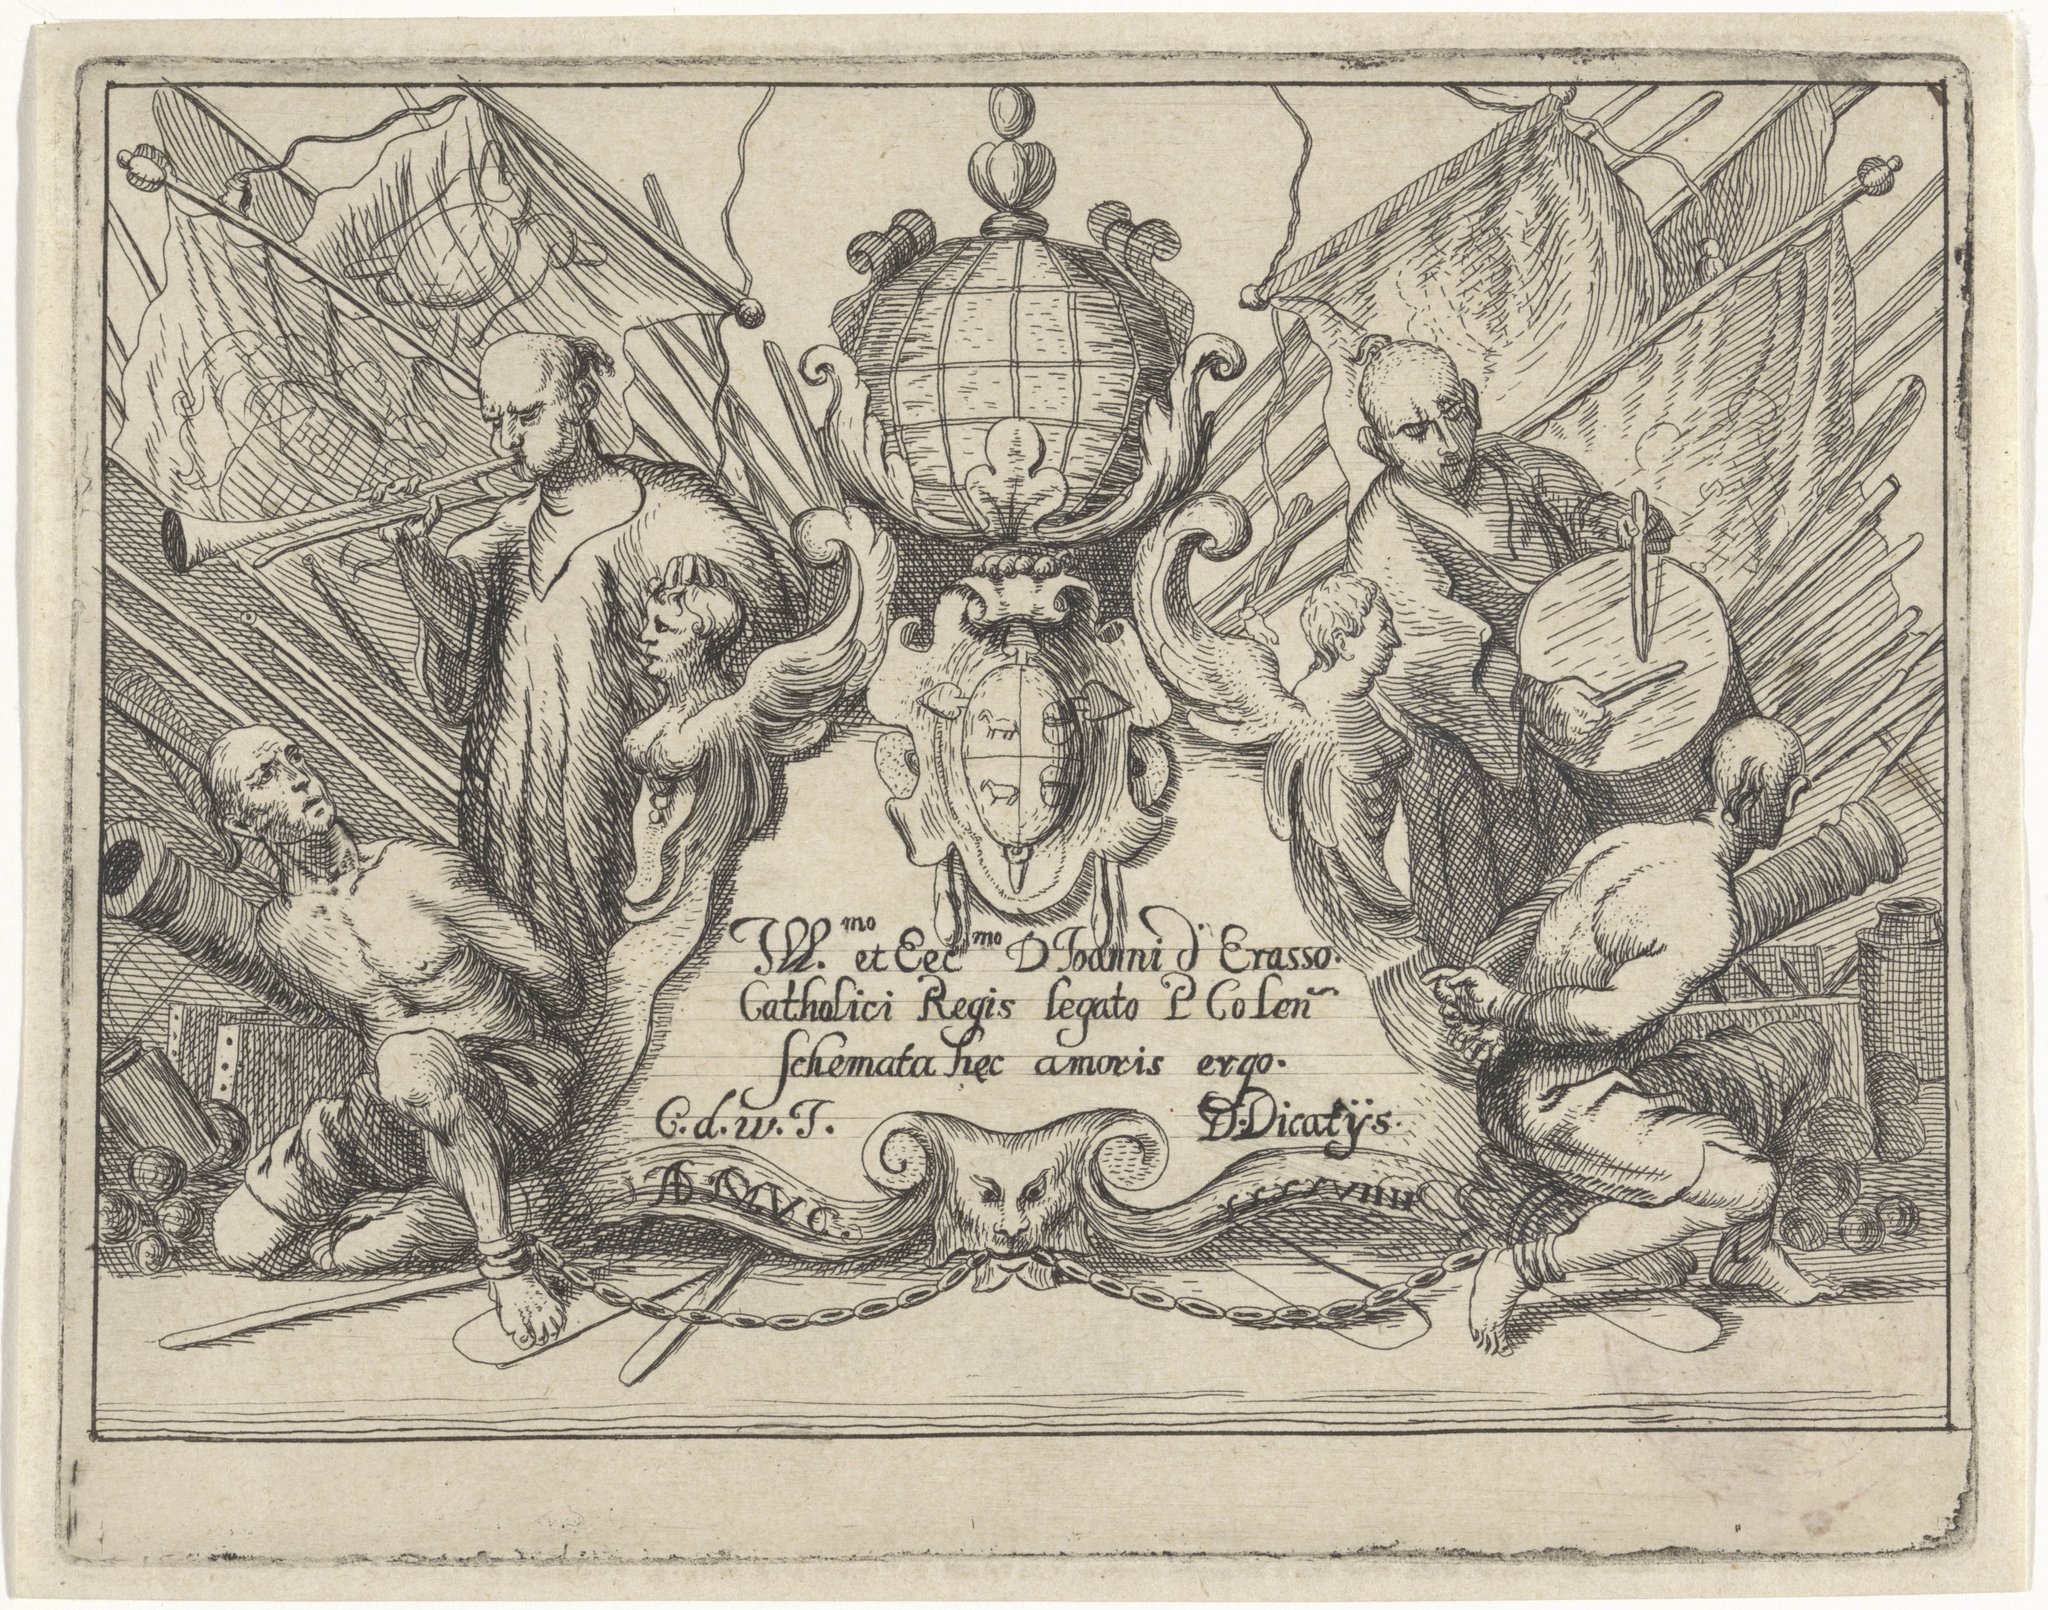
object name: titelprent, frontispice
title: Slaven en Aziatische figuren aan weerszijden van een cartouche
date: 1649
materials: paper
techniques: etching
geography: northern netherlands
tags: musician, slavery; serfs and enslaved persons, armorial bearing, heraldry, (military) flags and standards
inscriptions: collector's mark: Lugt 240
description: De cartouche in het midden bevat een opdracht in het Latijn en is versierd met het wapenschild van Joannes d'Erasso en twee gevleugelde vrouwenbusten. Aan weerszijden van de cartouche zit een geketende islamitische galeislaaf met onder zijn voeten roeispanen. Achter ieder van hen staat een islamitische galeislaaf met een muziekinstrument. De linker man bespeelt een trompet en de rechter een trommel. Deze tot slaaf gemaakte mannen zijn als moslims te herkennen door het typerende kapsel (hoofd op een pluk na kaalgeschoren) dat zij verplicht waren te hebben. Op de achtergrond kanonnen en verschillende vlaggen.